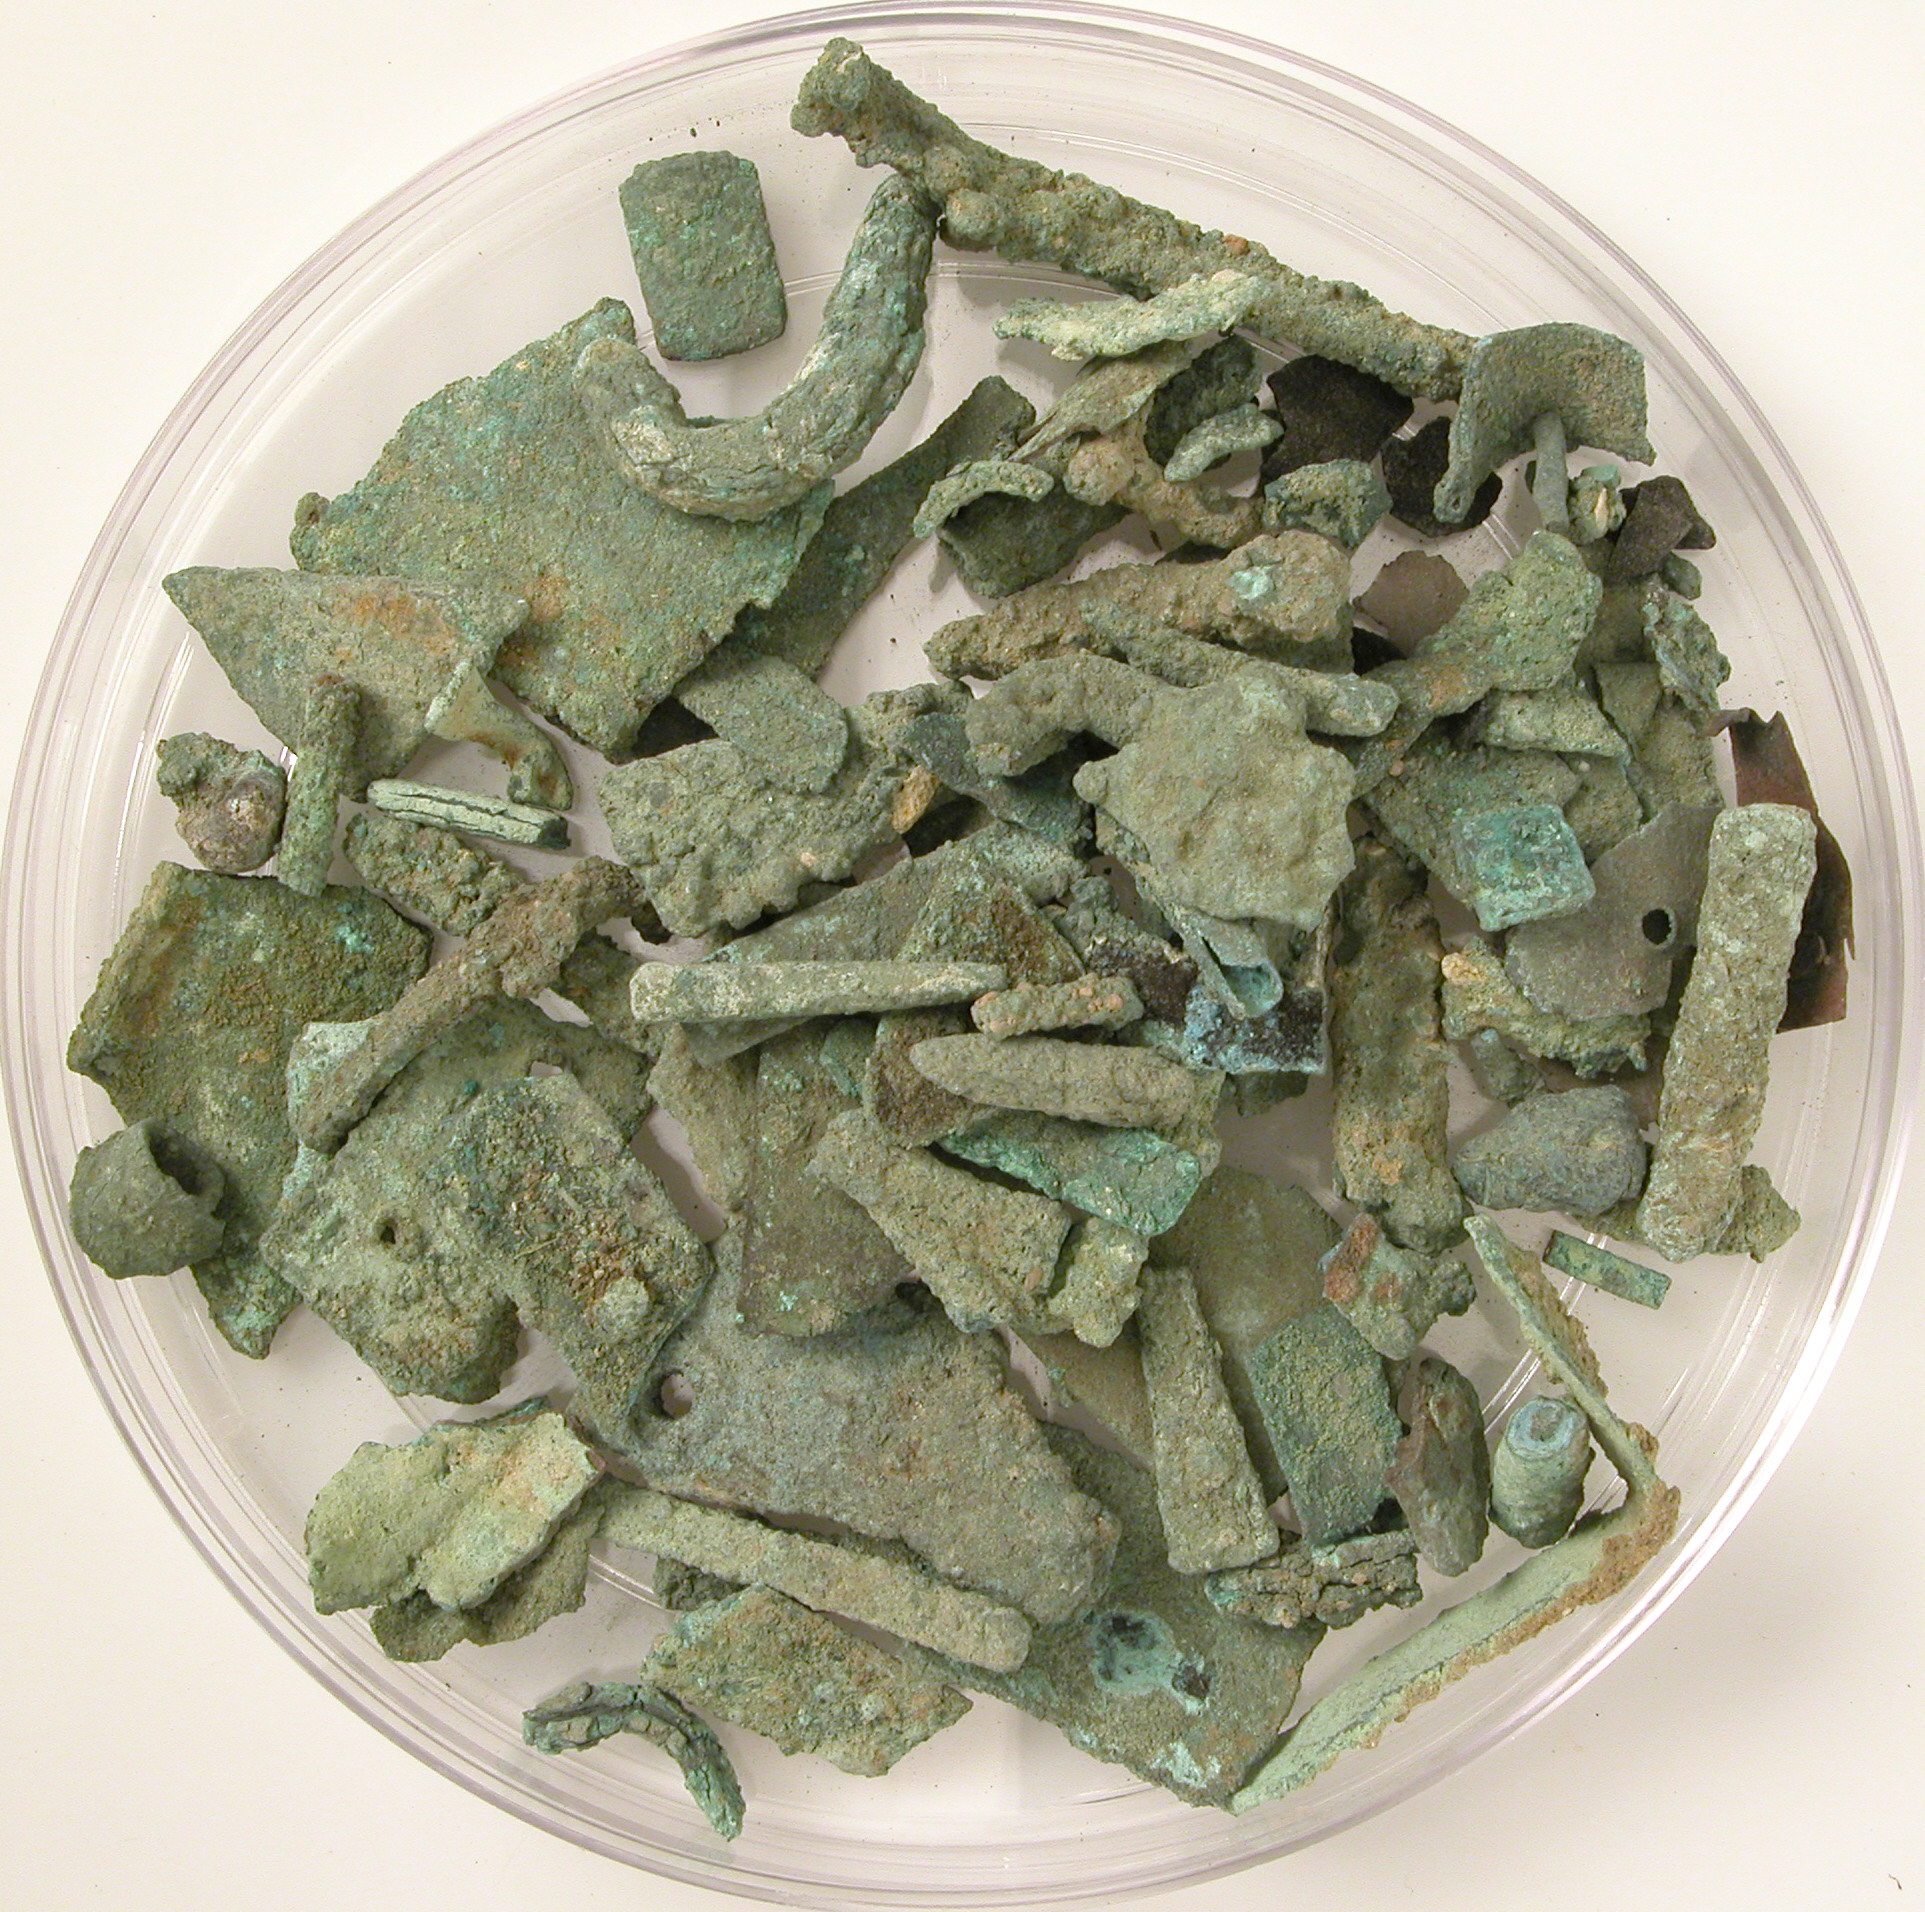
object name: fragment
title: Fragments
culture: coptic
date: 301-700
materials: copper alloy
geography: egypt